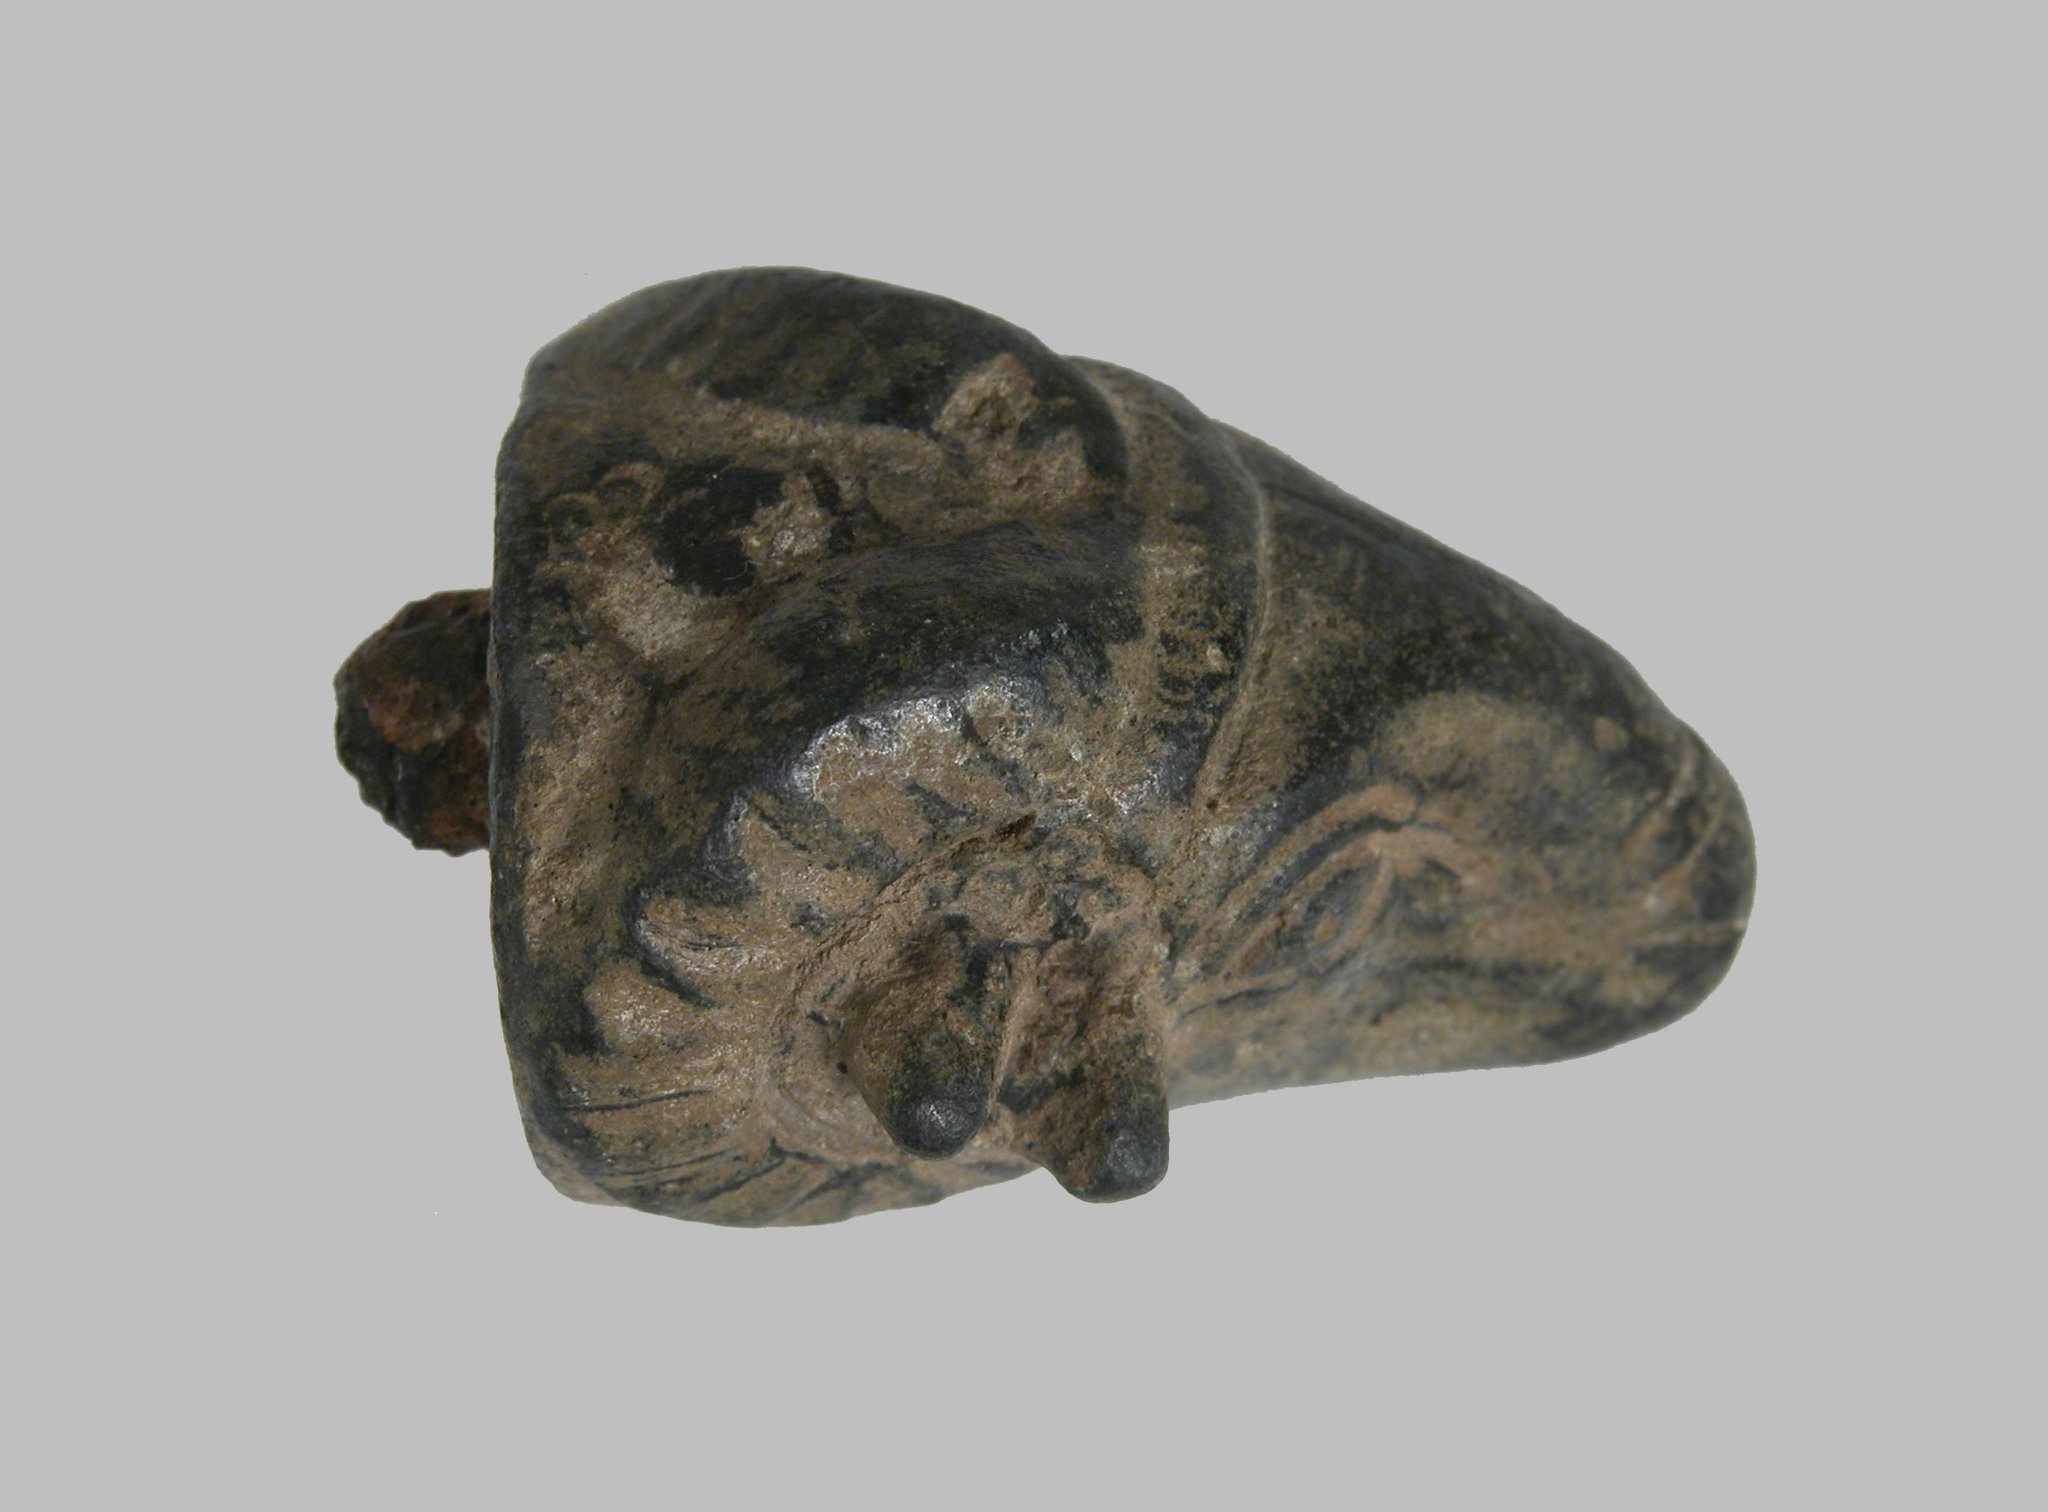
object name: key handle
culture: roman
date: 1-700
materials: copper alloy